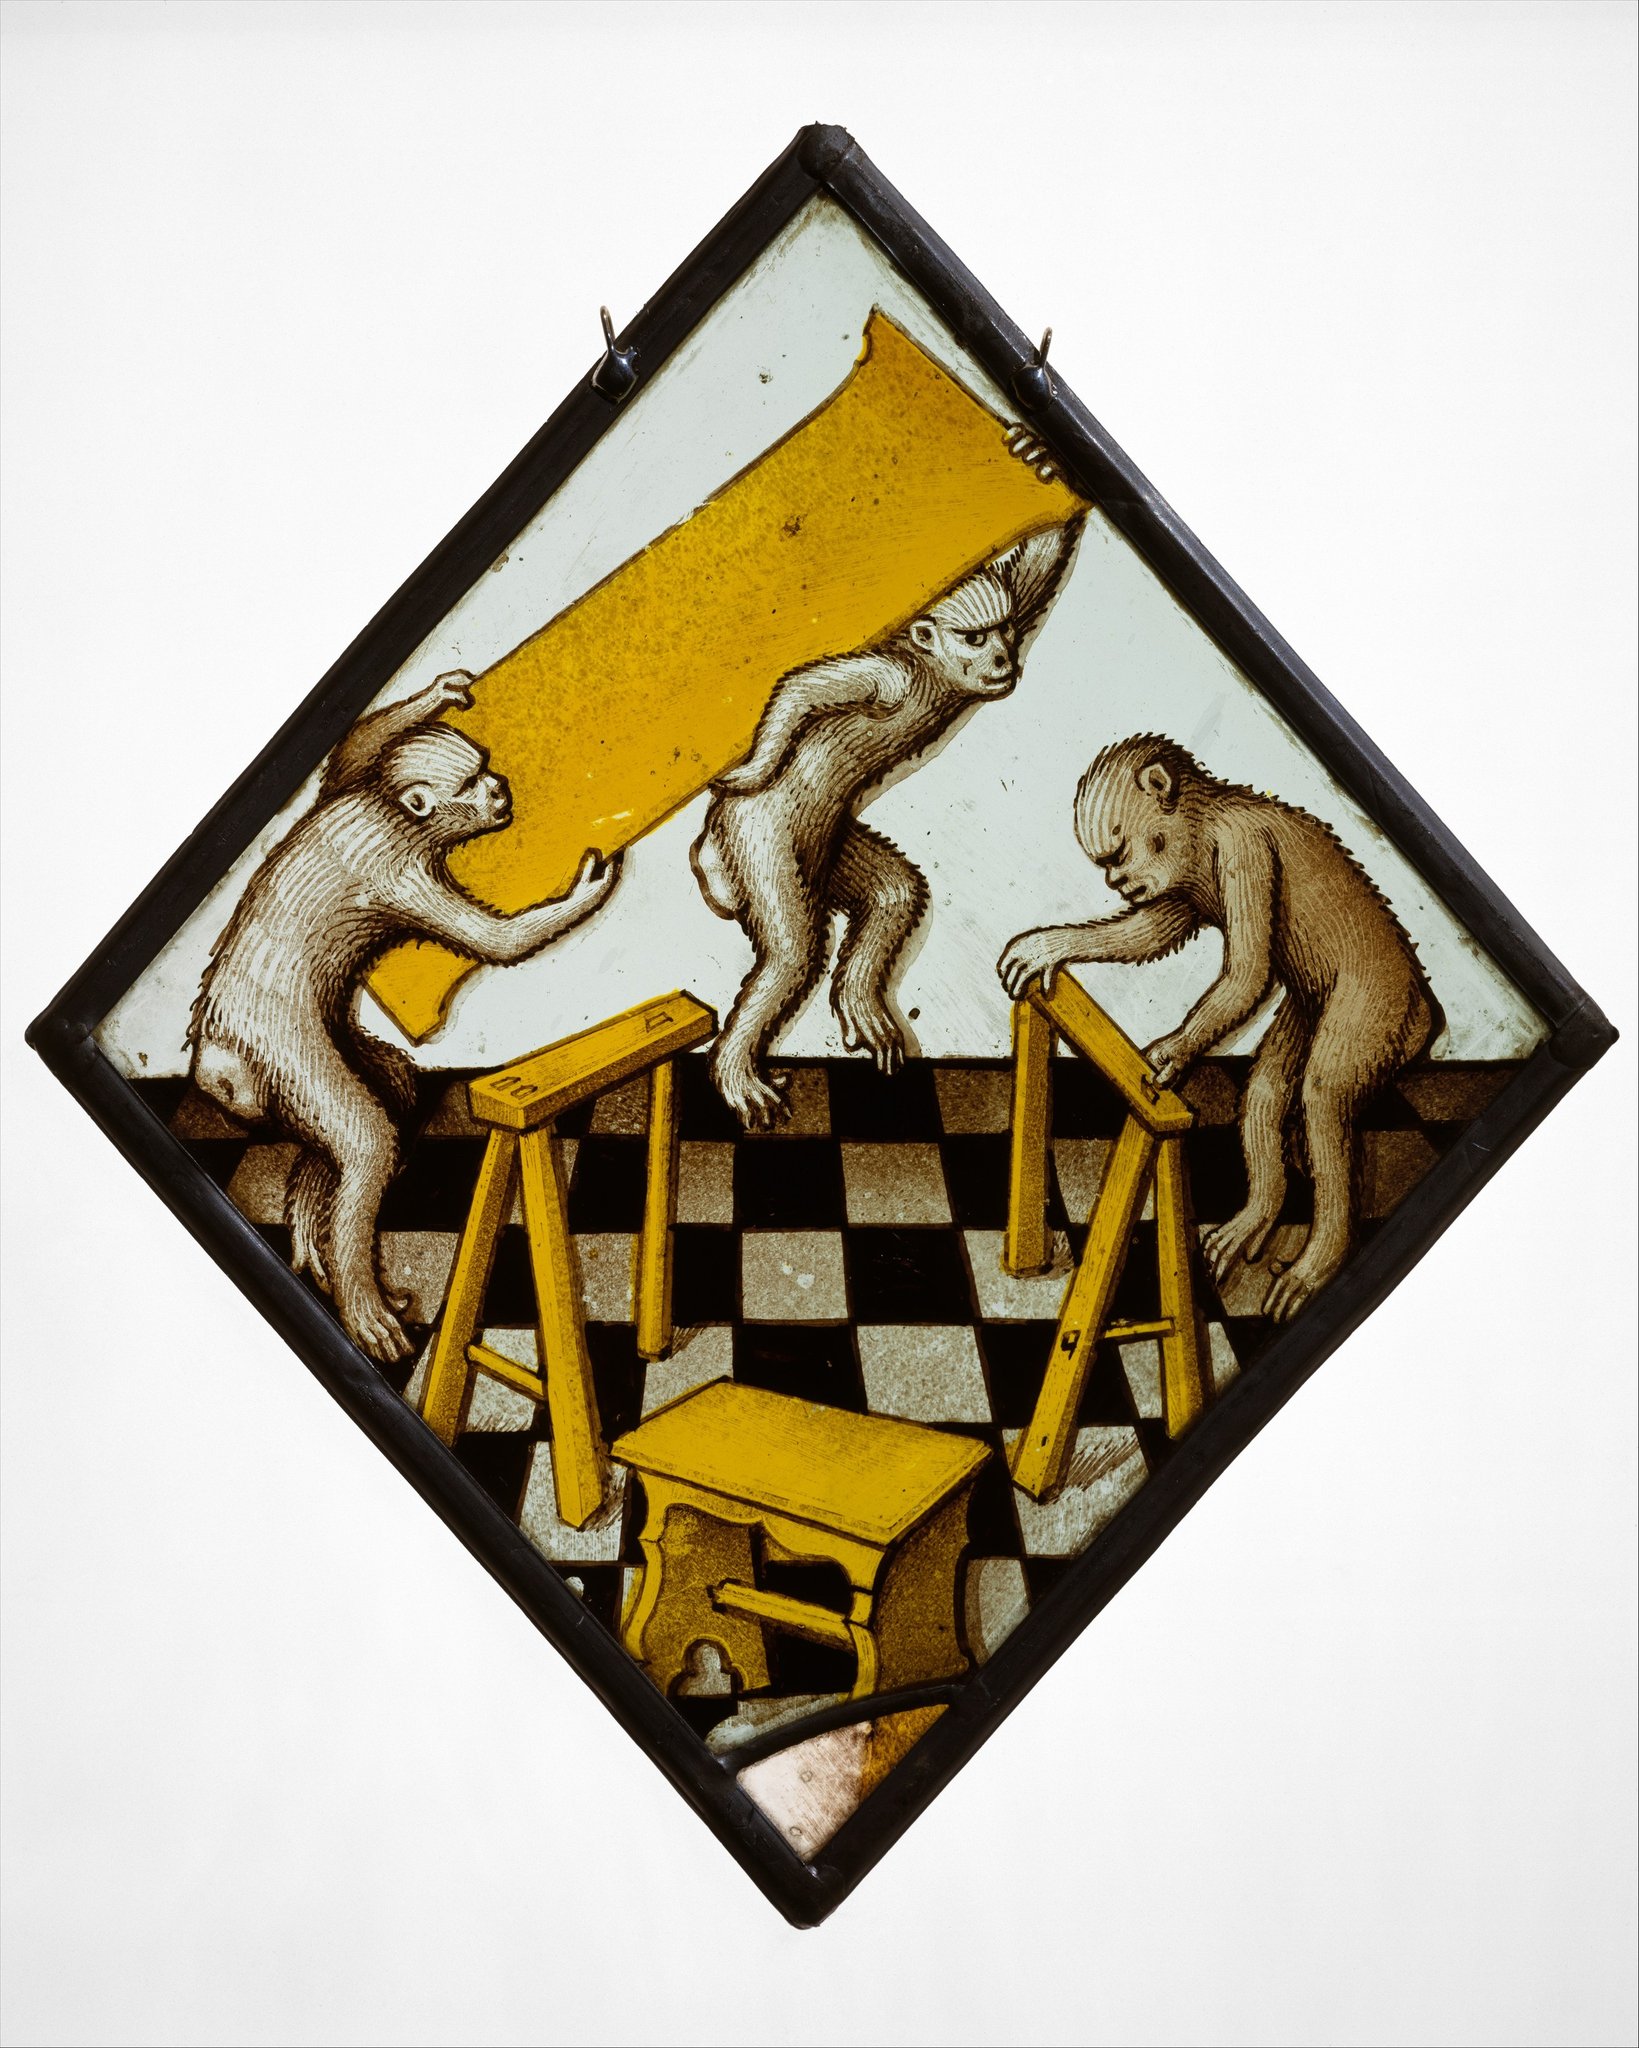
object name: roundel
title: Roundel with Three Apes Building a Trestle Table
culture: german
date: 1480-1500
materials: glass, paint, pigment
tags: tables,apes